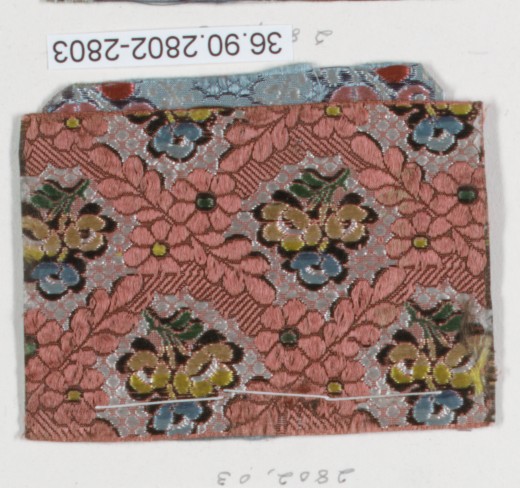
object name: piece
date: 1801-1900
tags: flowers,leaves